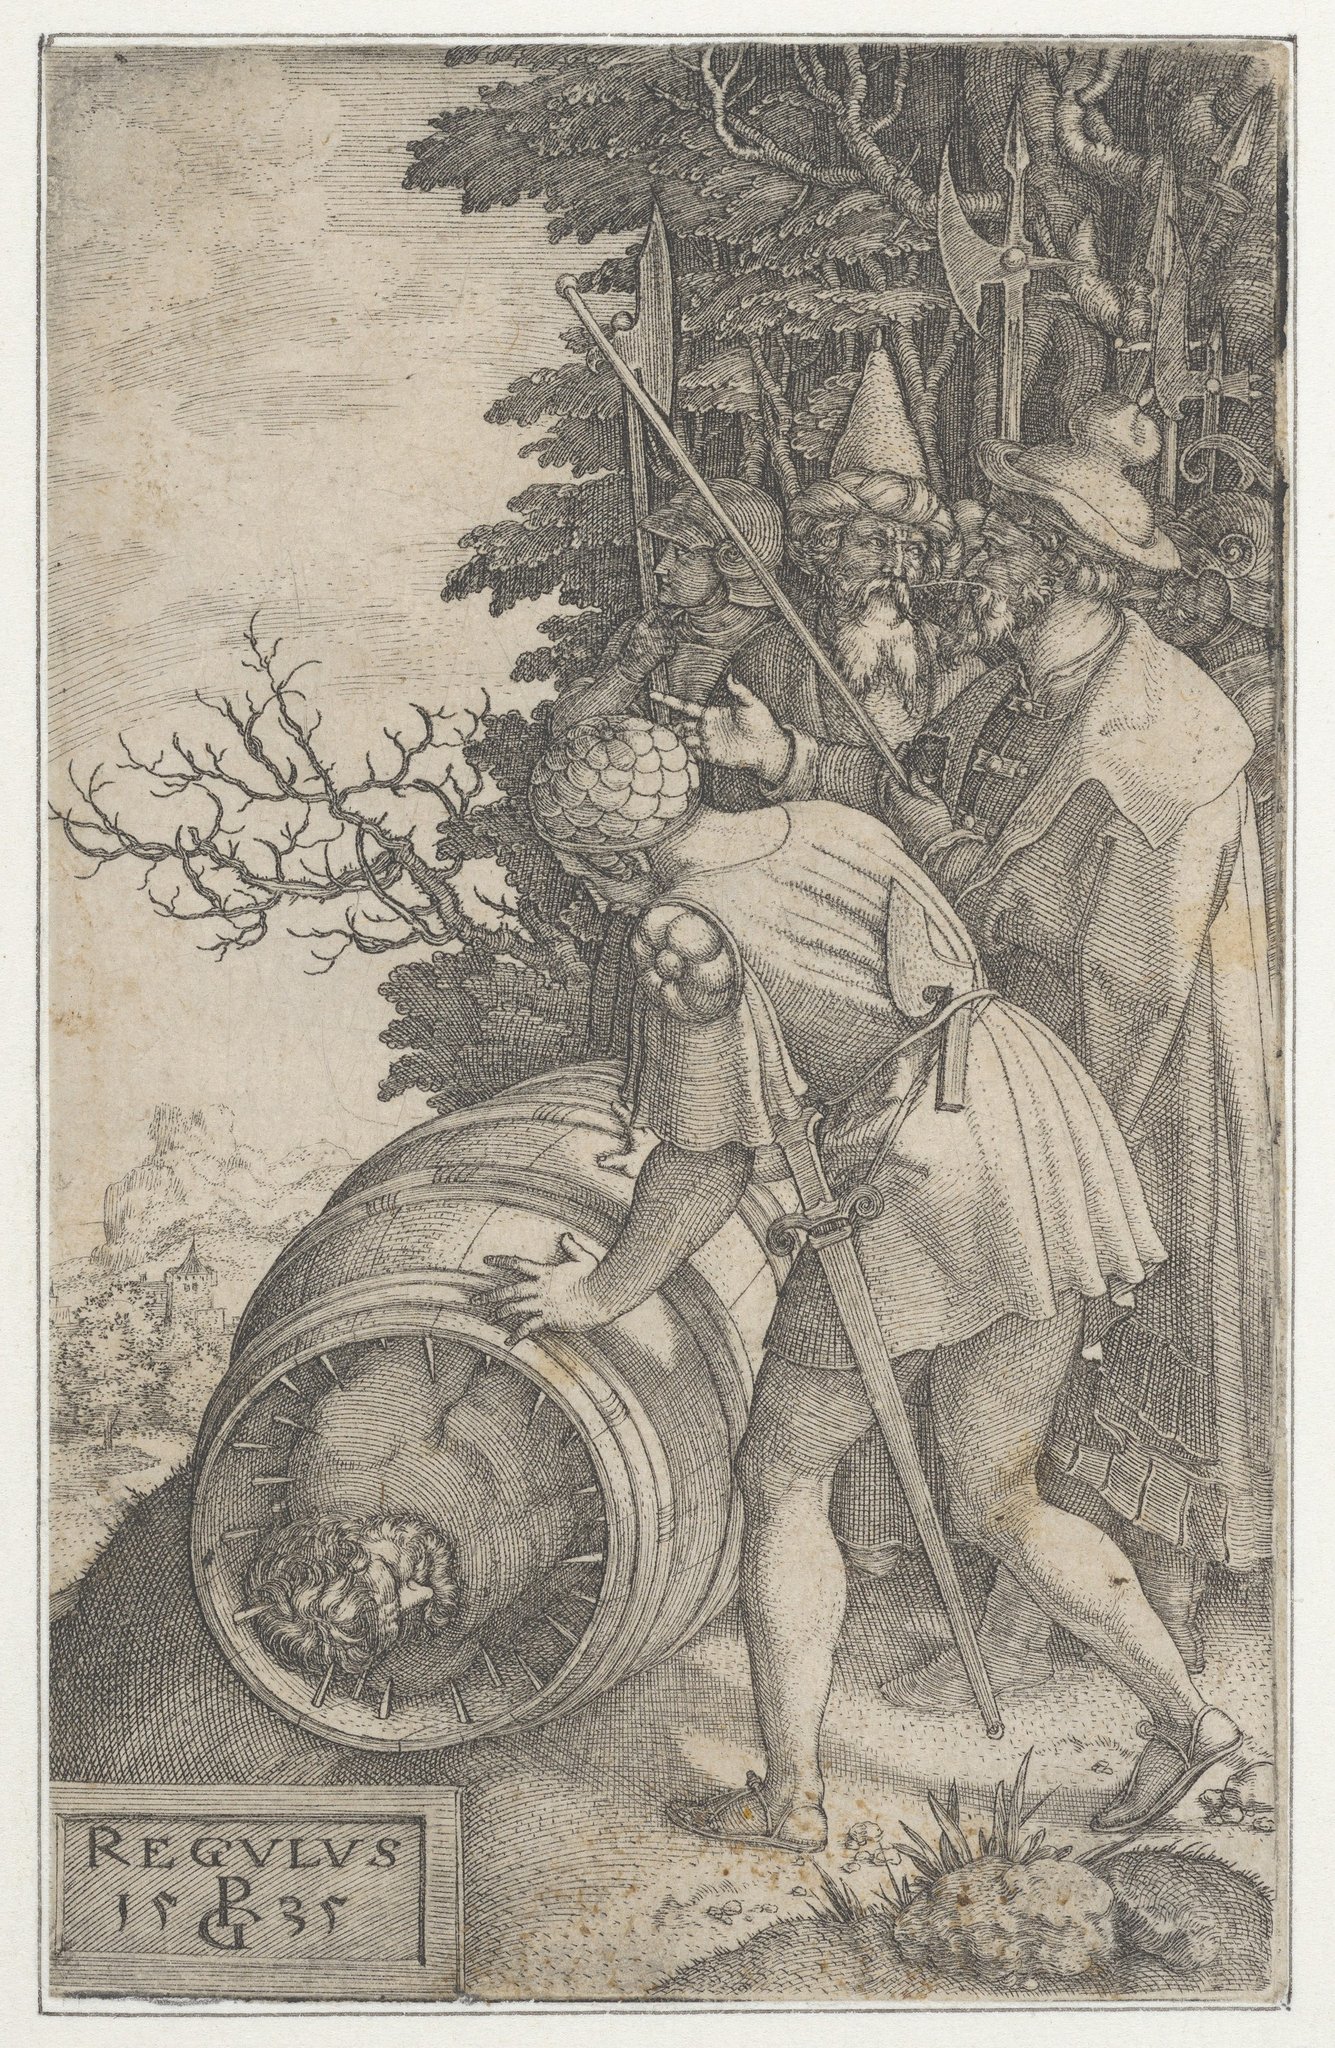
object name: print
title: Attilius Regulus, from Roman Heroes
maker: georg pencz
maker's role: artist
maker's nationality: german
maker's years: 1500-1550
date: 1535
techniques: engraving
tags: weapons,men,punishment